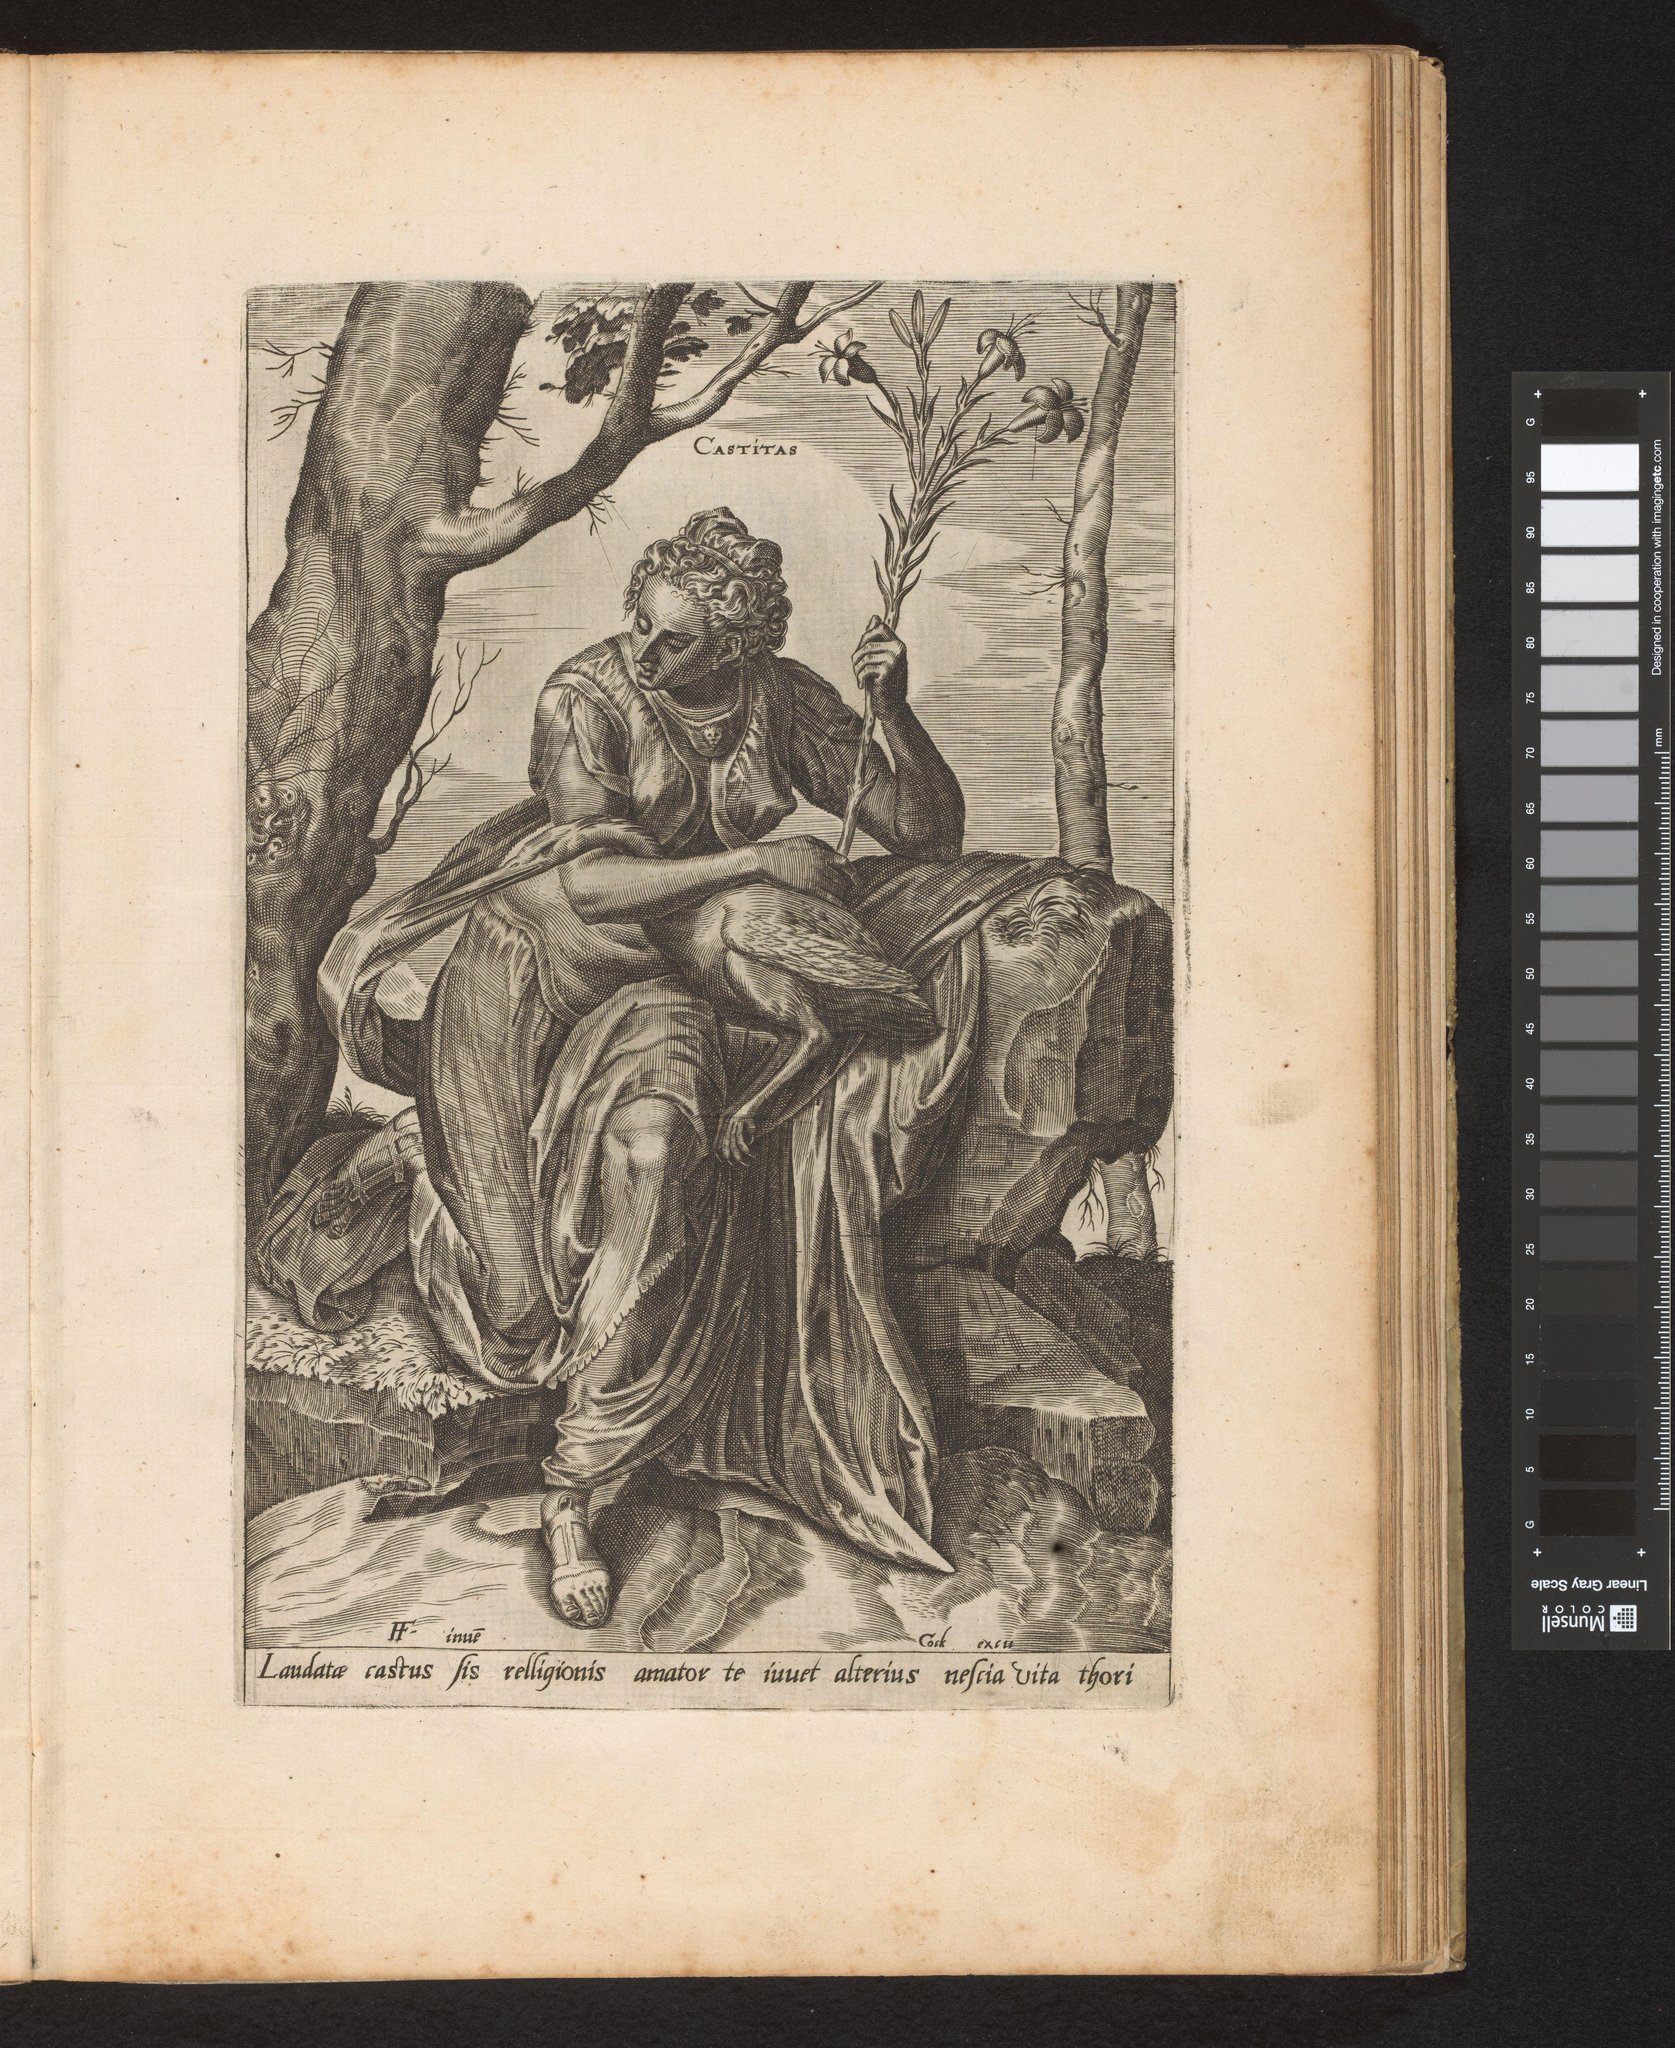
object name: print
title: Castitas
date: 1560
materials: paper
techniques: engraving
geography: antwerp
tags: 'castità ', 'pudicitia', 'vergogna honesta' (ripa)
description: De personificatie van de Kuisheid houdt een ooievaar en een lelie in haar handen. De lelie verwijst naar de kuisheid van Maria en ook de ooievaar staat symbool voor het weerstaan van de verleiding. Deze prent maakt deel uit van een album.